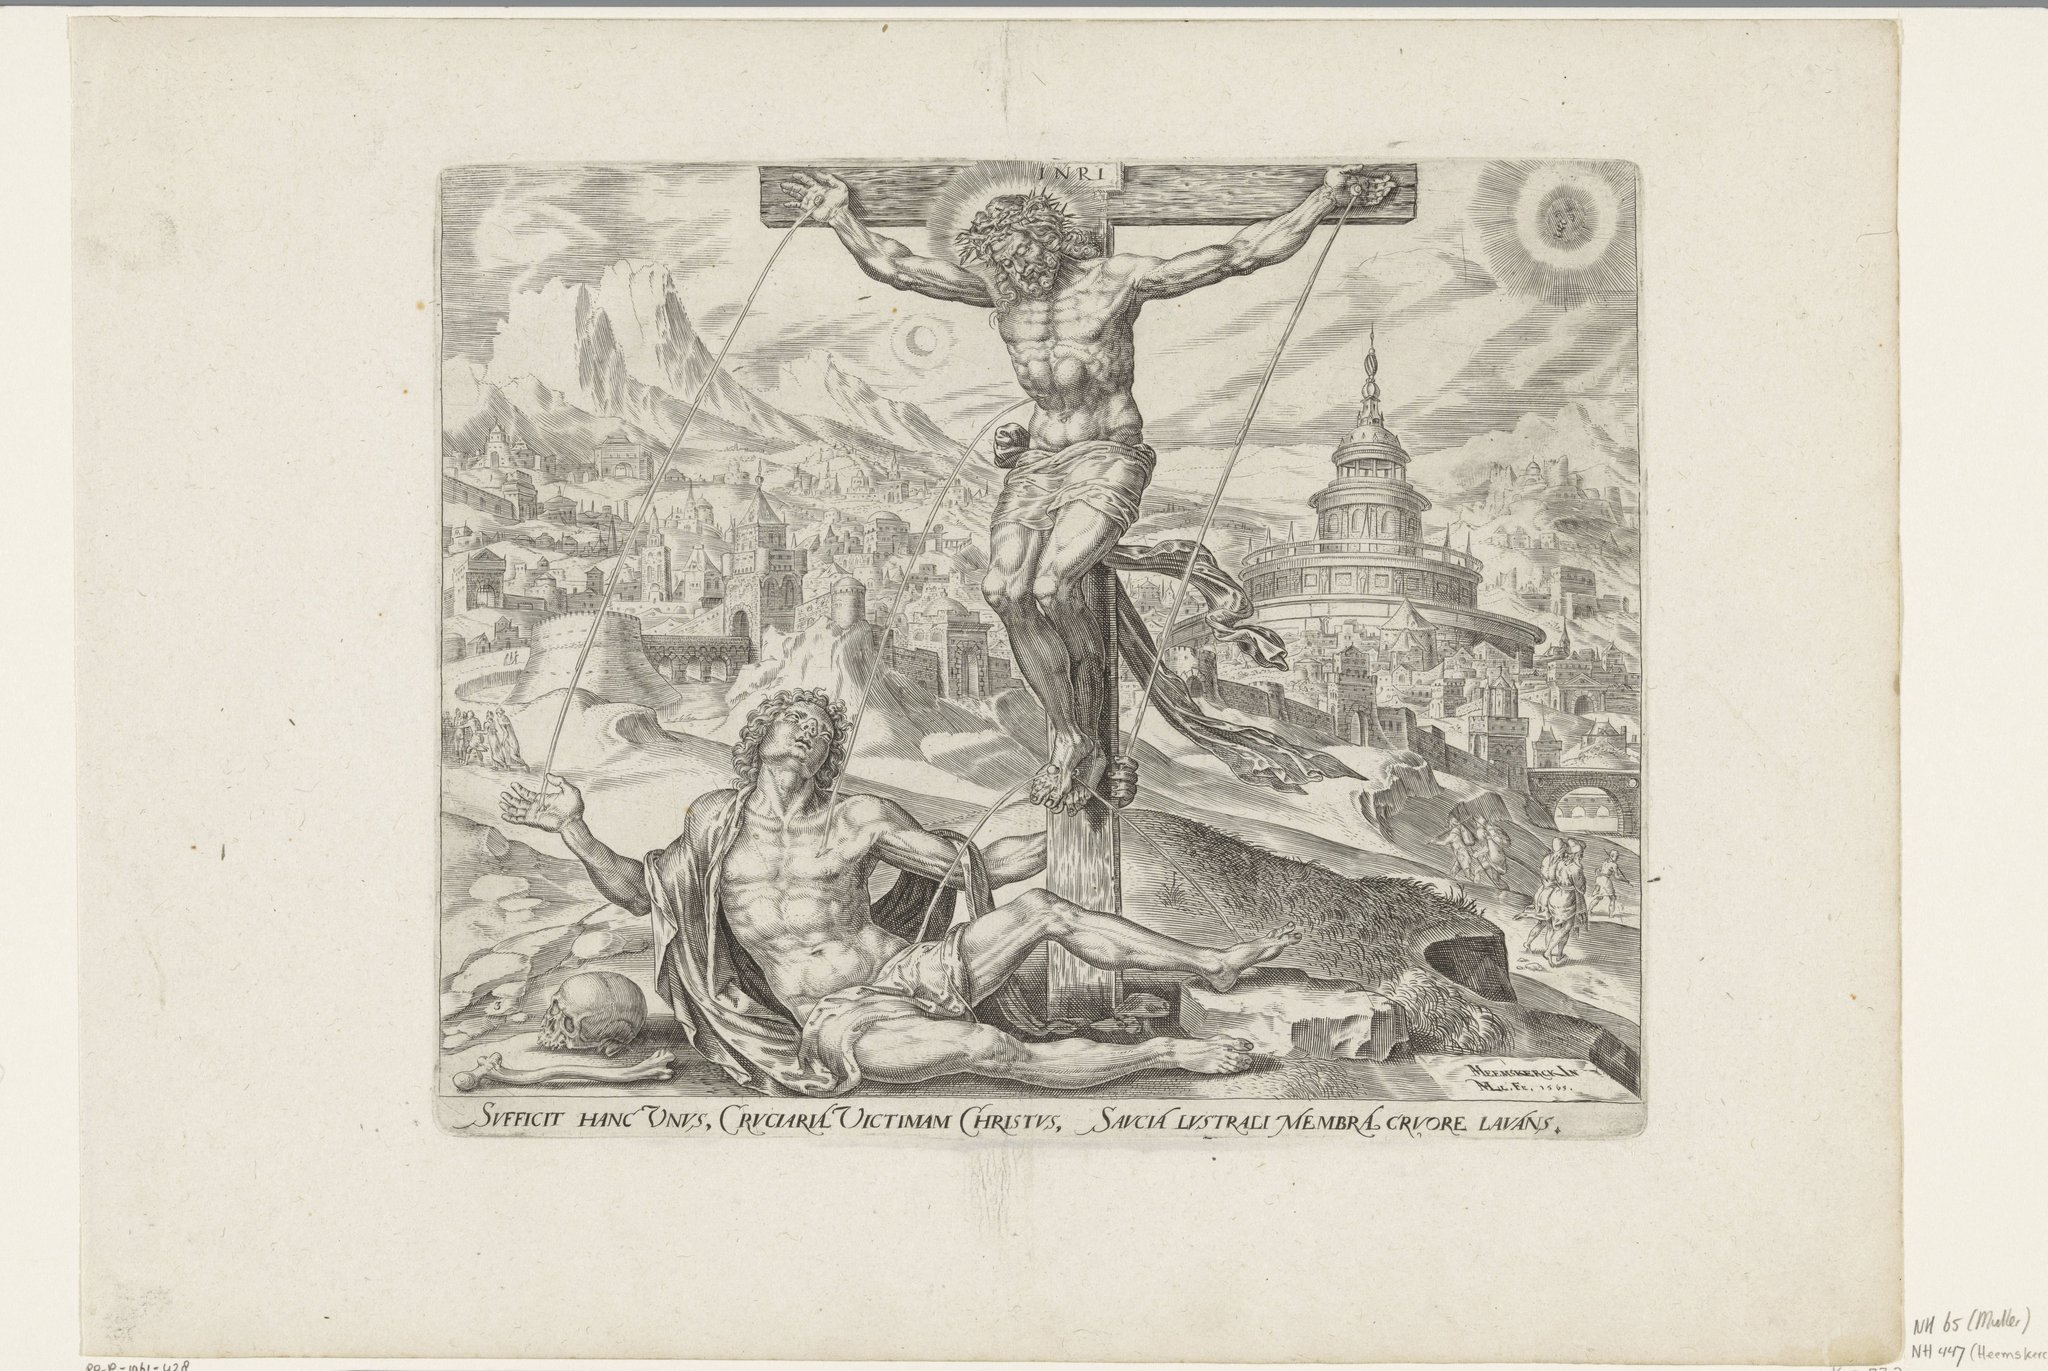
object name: print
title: Christus als de barmhartige Samaritaan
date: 1565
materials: paper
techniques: engraving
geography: amsterdam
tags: city-view, and landscape with man-made constructions, the good samaritan (luke 10:30-37) (+ variant), the crucifixion of christ: prelude to christ's death on the cross (matthew 27:34-44; mark 15:23-32; luke 23:33-43; john 19:18-24), christ on the cross (in a fountain), shedding his blood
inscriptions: collector's mark: Lugt 2228, collector's mark: Lugt 2760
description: De gewonde Mens wordt genezen door het bloed van Christus dat op hem valt, terwijl hij onder het kruis ligt. Op de achtergrond een stad. Onderaan in de marge een vers in het Latijn. Variant op de gelijkenis van de barmhartige Samaritaan.